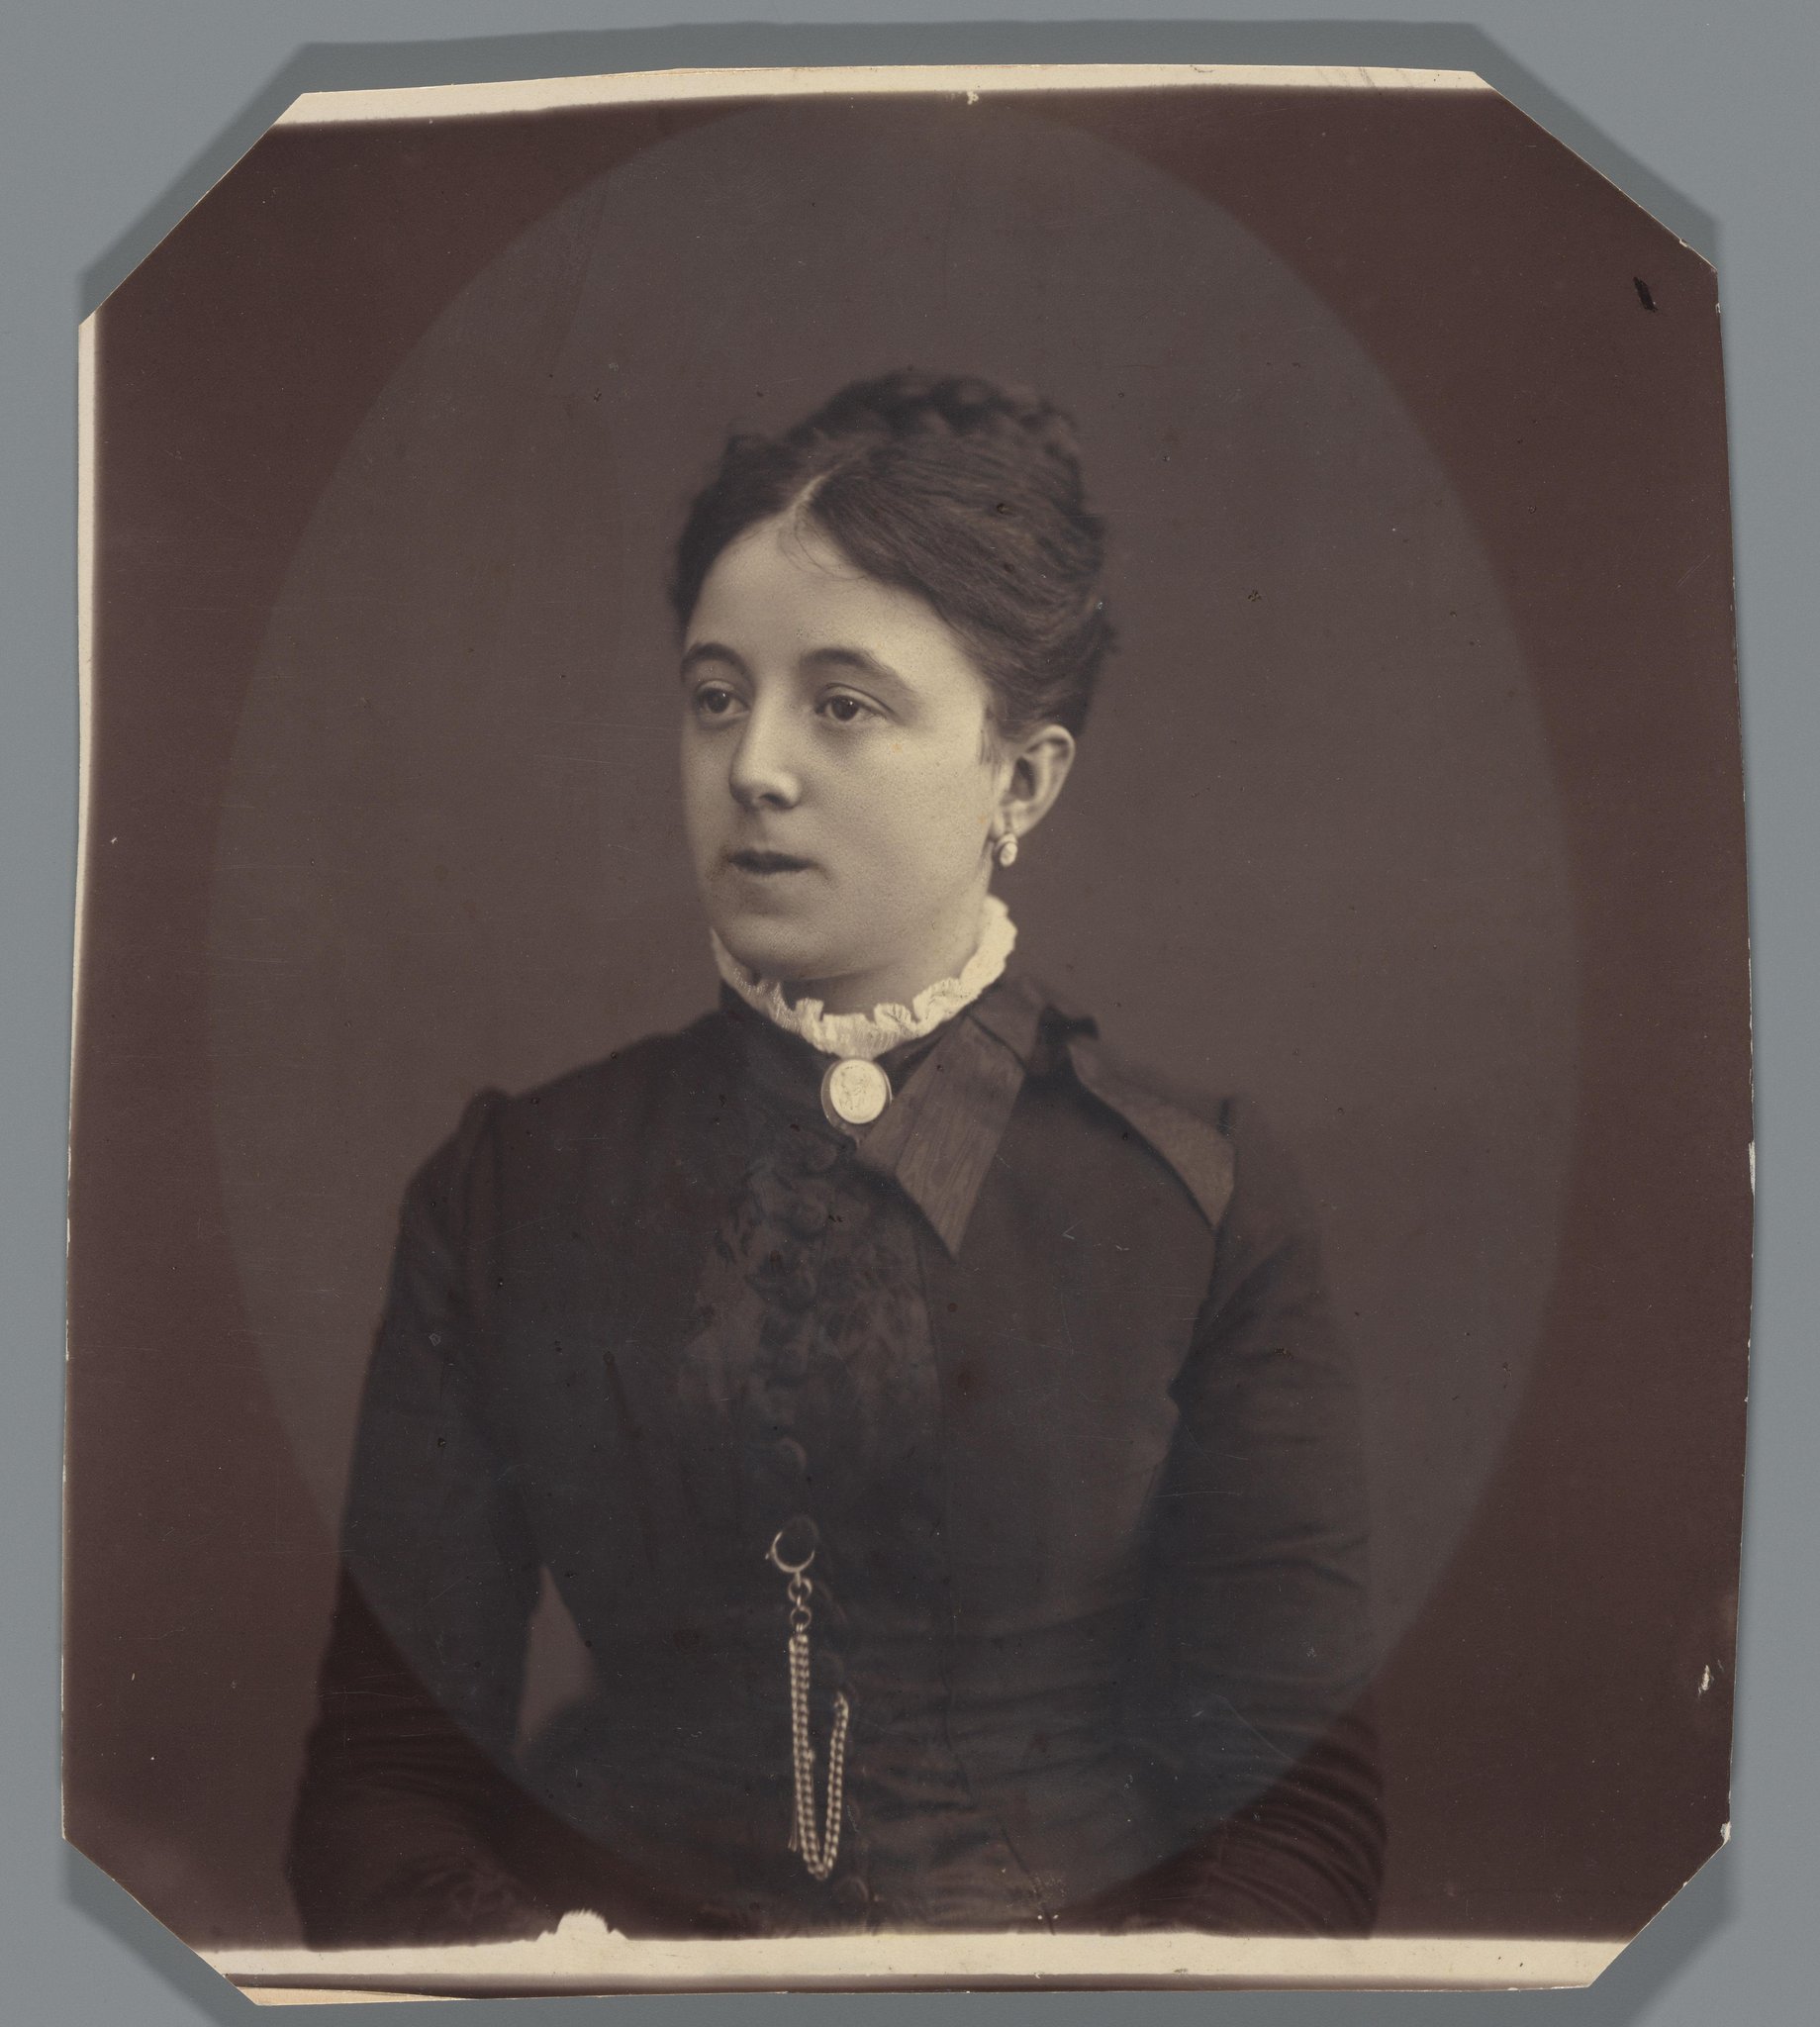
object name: photograph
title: Portret van een onbekende vrouw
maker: Anonymous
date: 1880-1910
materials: paper, cardboard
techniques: gelatin silver print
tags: anonymous historical person portrayed - bb - woman